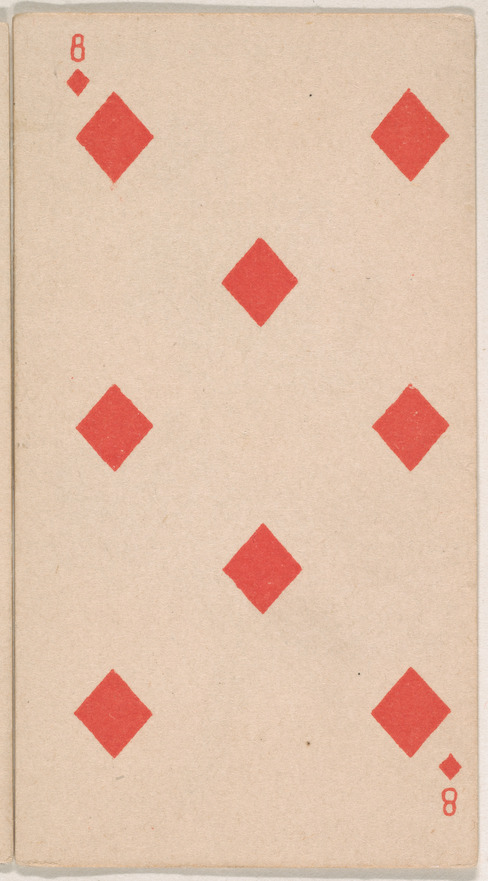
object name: print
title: Eight of Diamonds, from the Transparent Playing Cards series (N220) issued by Kinney Bros.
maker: kinney brothers tobacco company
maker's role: publisher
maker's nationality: american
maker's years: 1869-2011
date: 1888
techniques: color lithograph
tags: playing cards